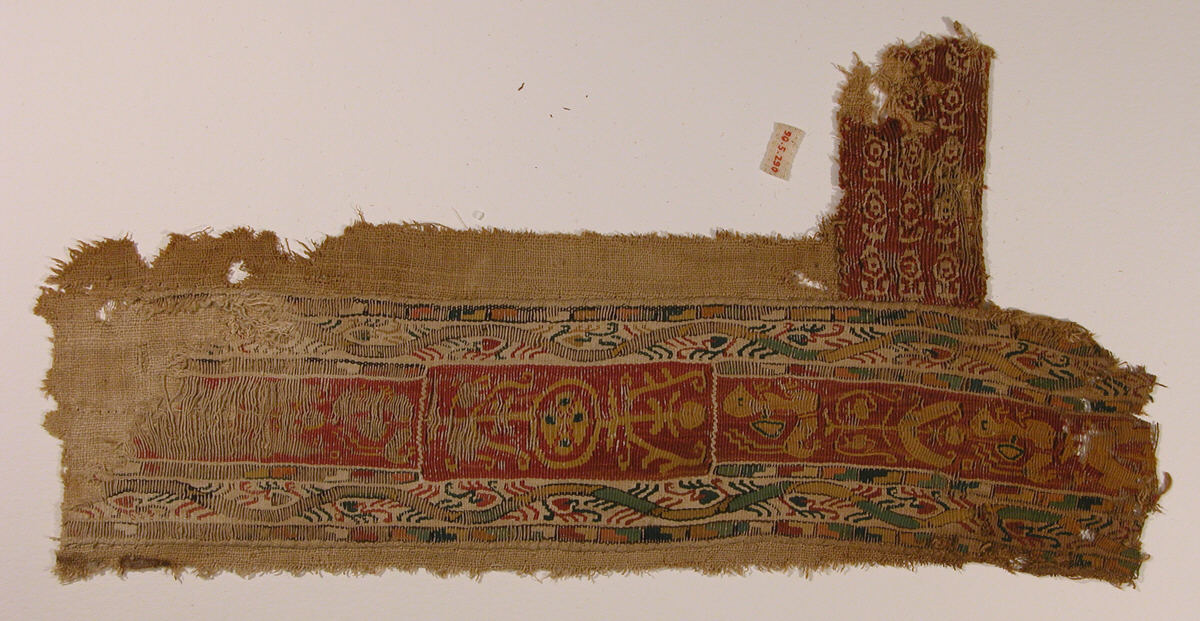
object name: textile fragment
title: Fragment of a Tunic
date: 501-600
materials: linen, wool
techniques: weave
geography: egypt